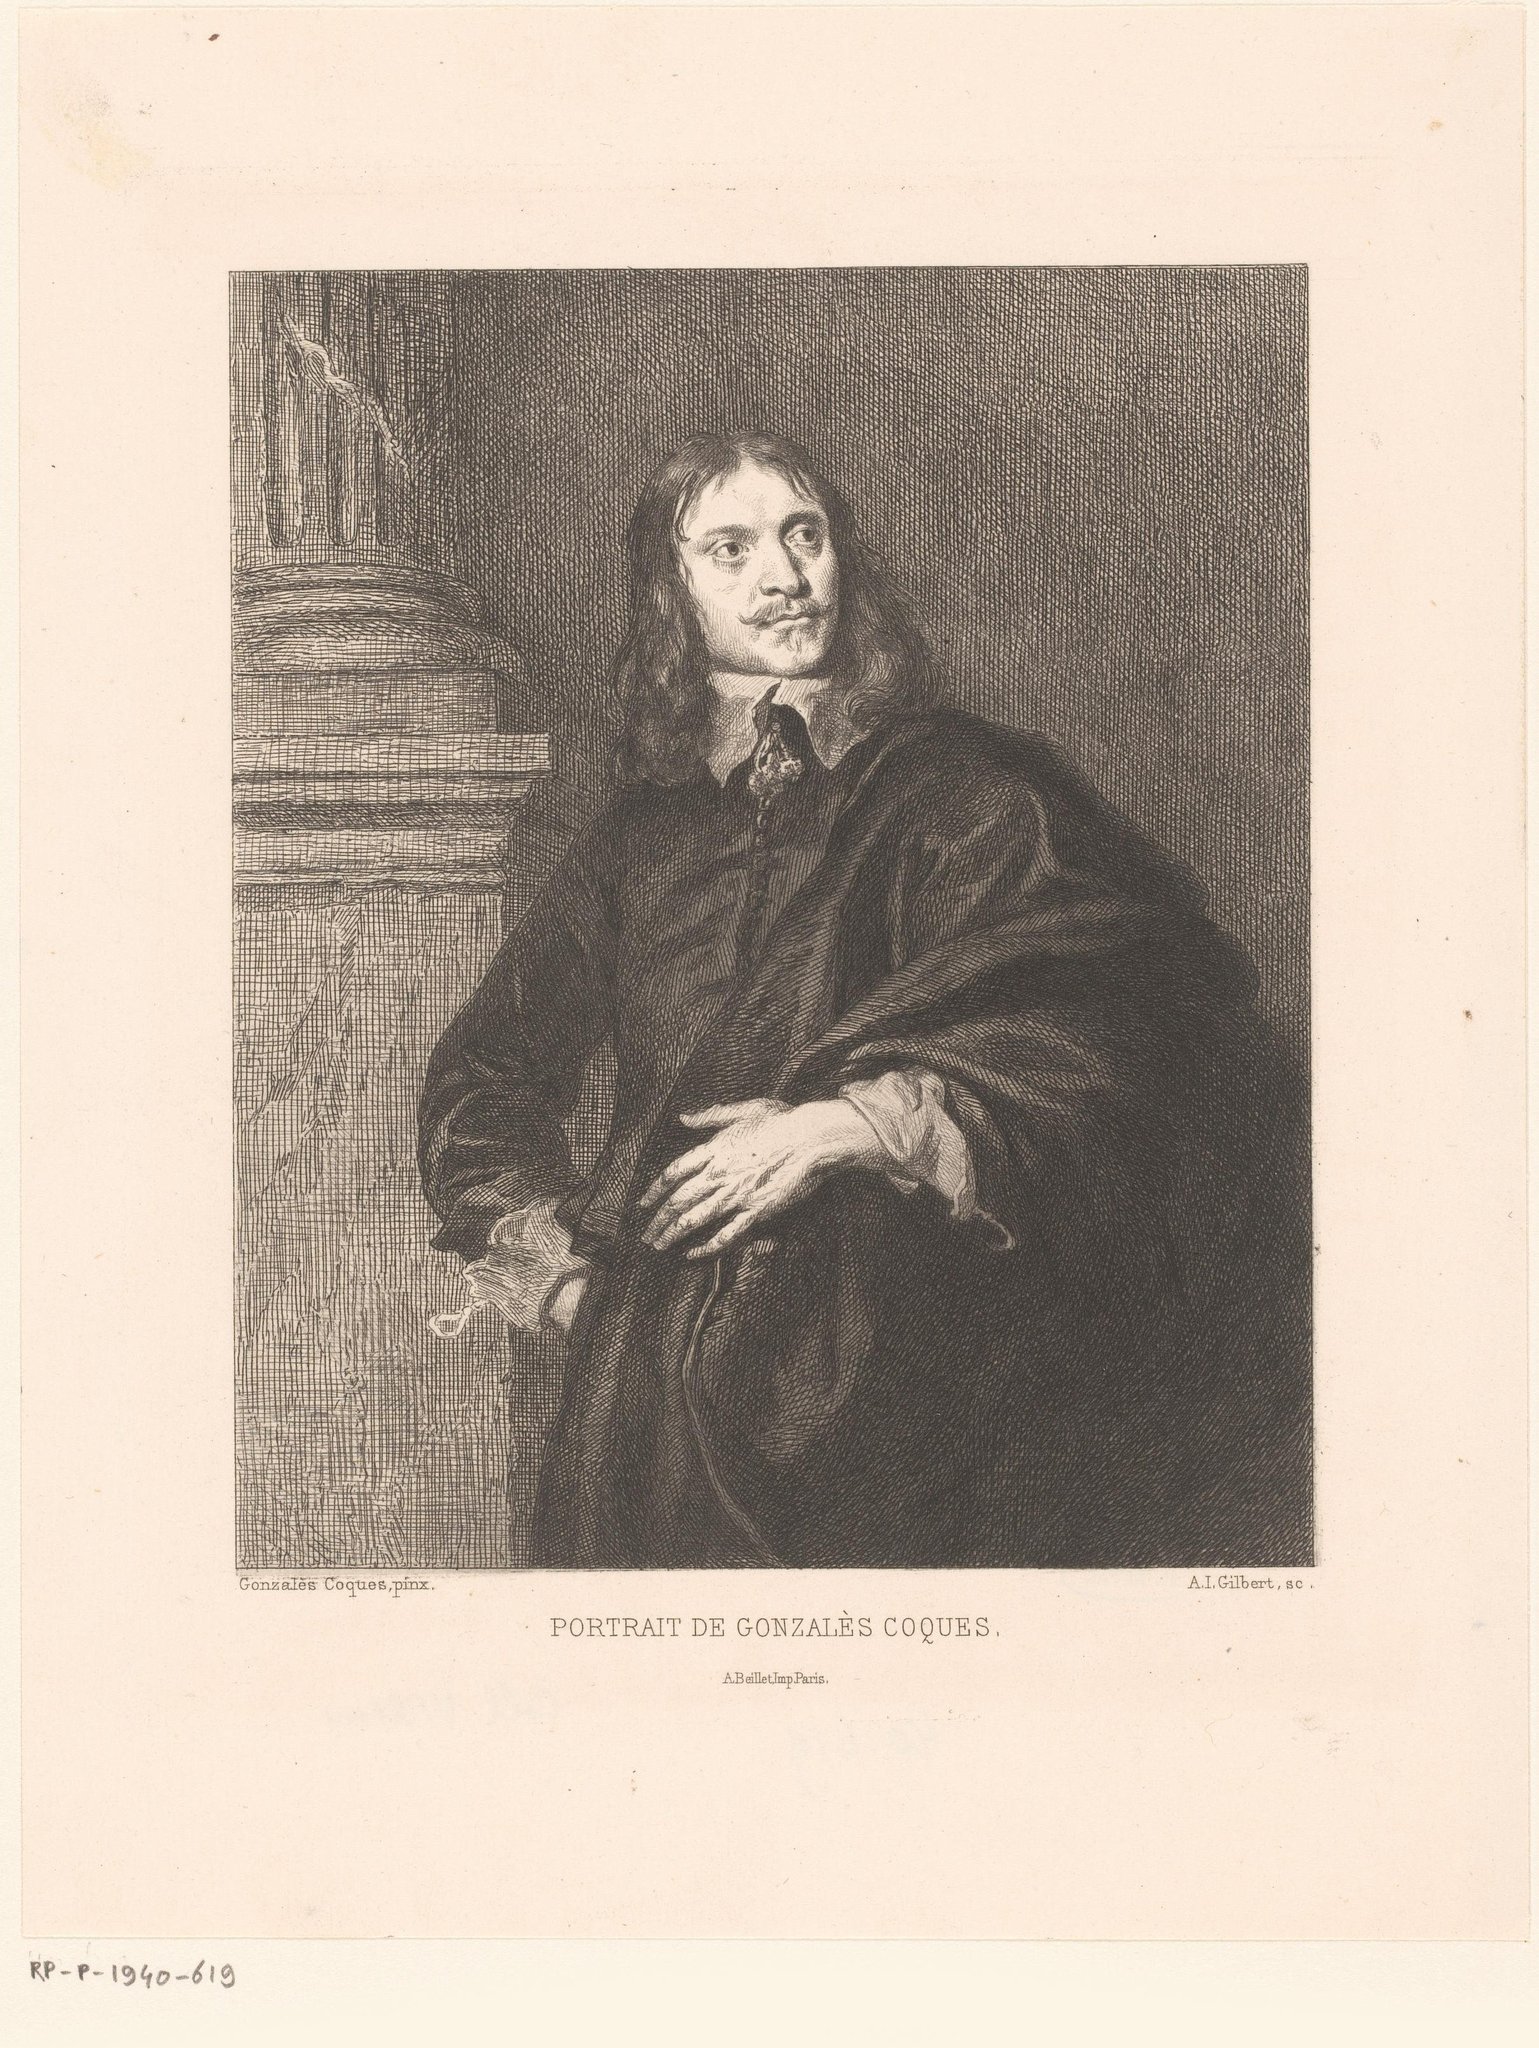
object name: print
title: Portret van Gonsalez Coques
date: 1838-1899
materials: paper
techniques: etching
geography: paris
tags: antwerp, draughtsman, gonzales coques, historical persons, portrait, self-portrait of artist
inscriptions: collector's mark: Lugt 2228, collector's mark: Lugt 2760